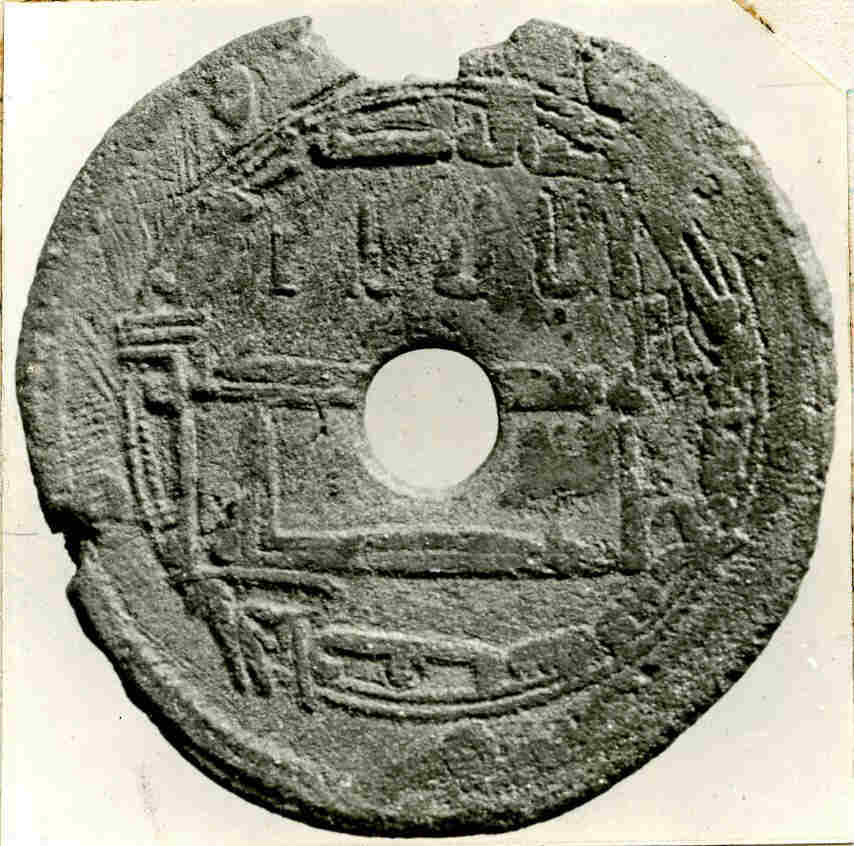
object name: coin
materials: copper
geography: al-rafiqa